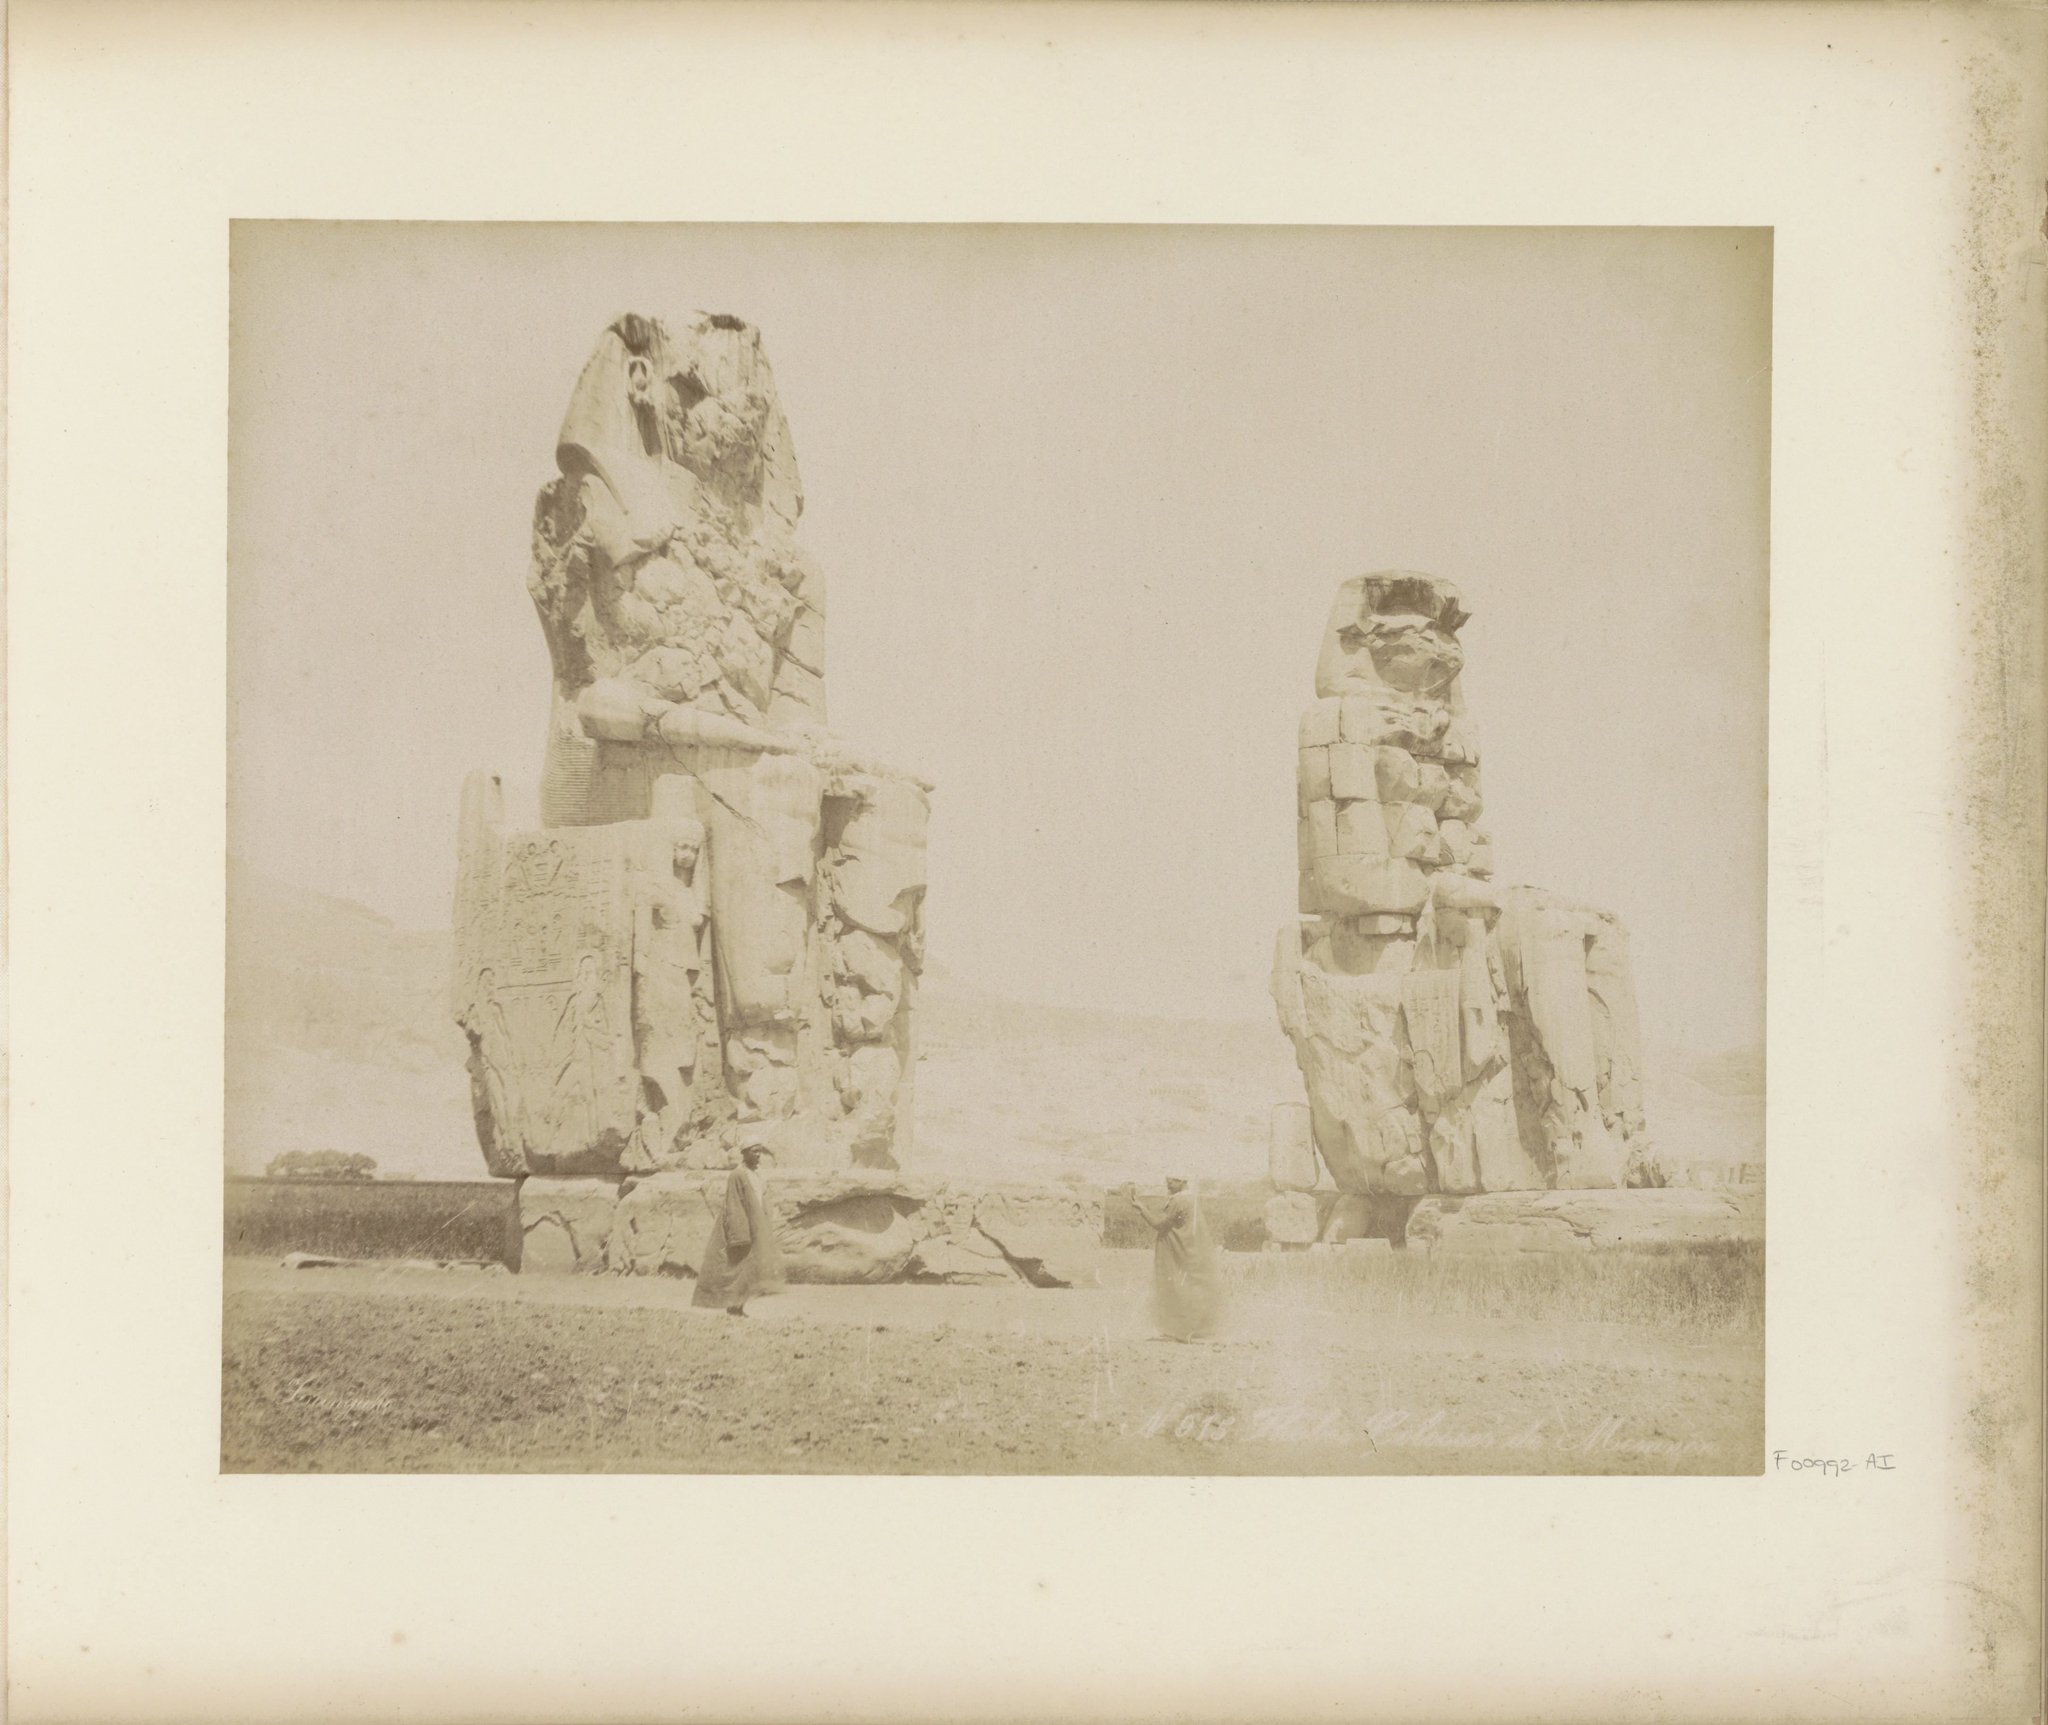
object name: photograph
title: Thebes Colosses de Memmon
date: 1870-1890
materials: cardboard, paper, photographic support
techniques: albumen print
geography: thebes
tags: giants, colossi, thebes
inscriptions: negative number: ‘915’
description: Onderdeel van Reisalbum met 80 foto's van Egypte.